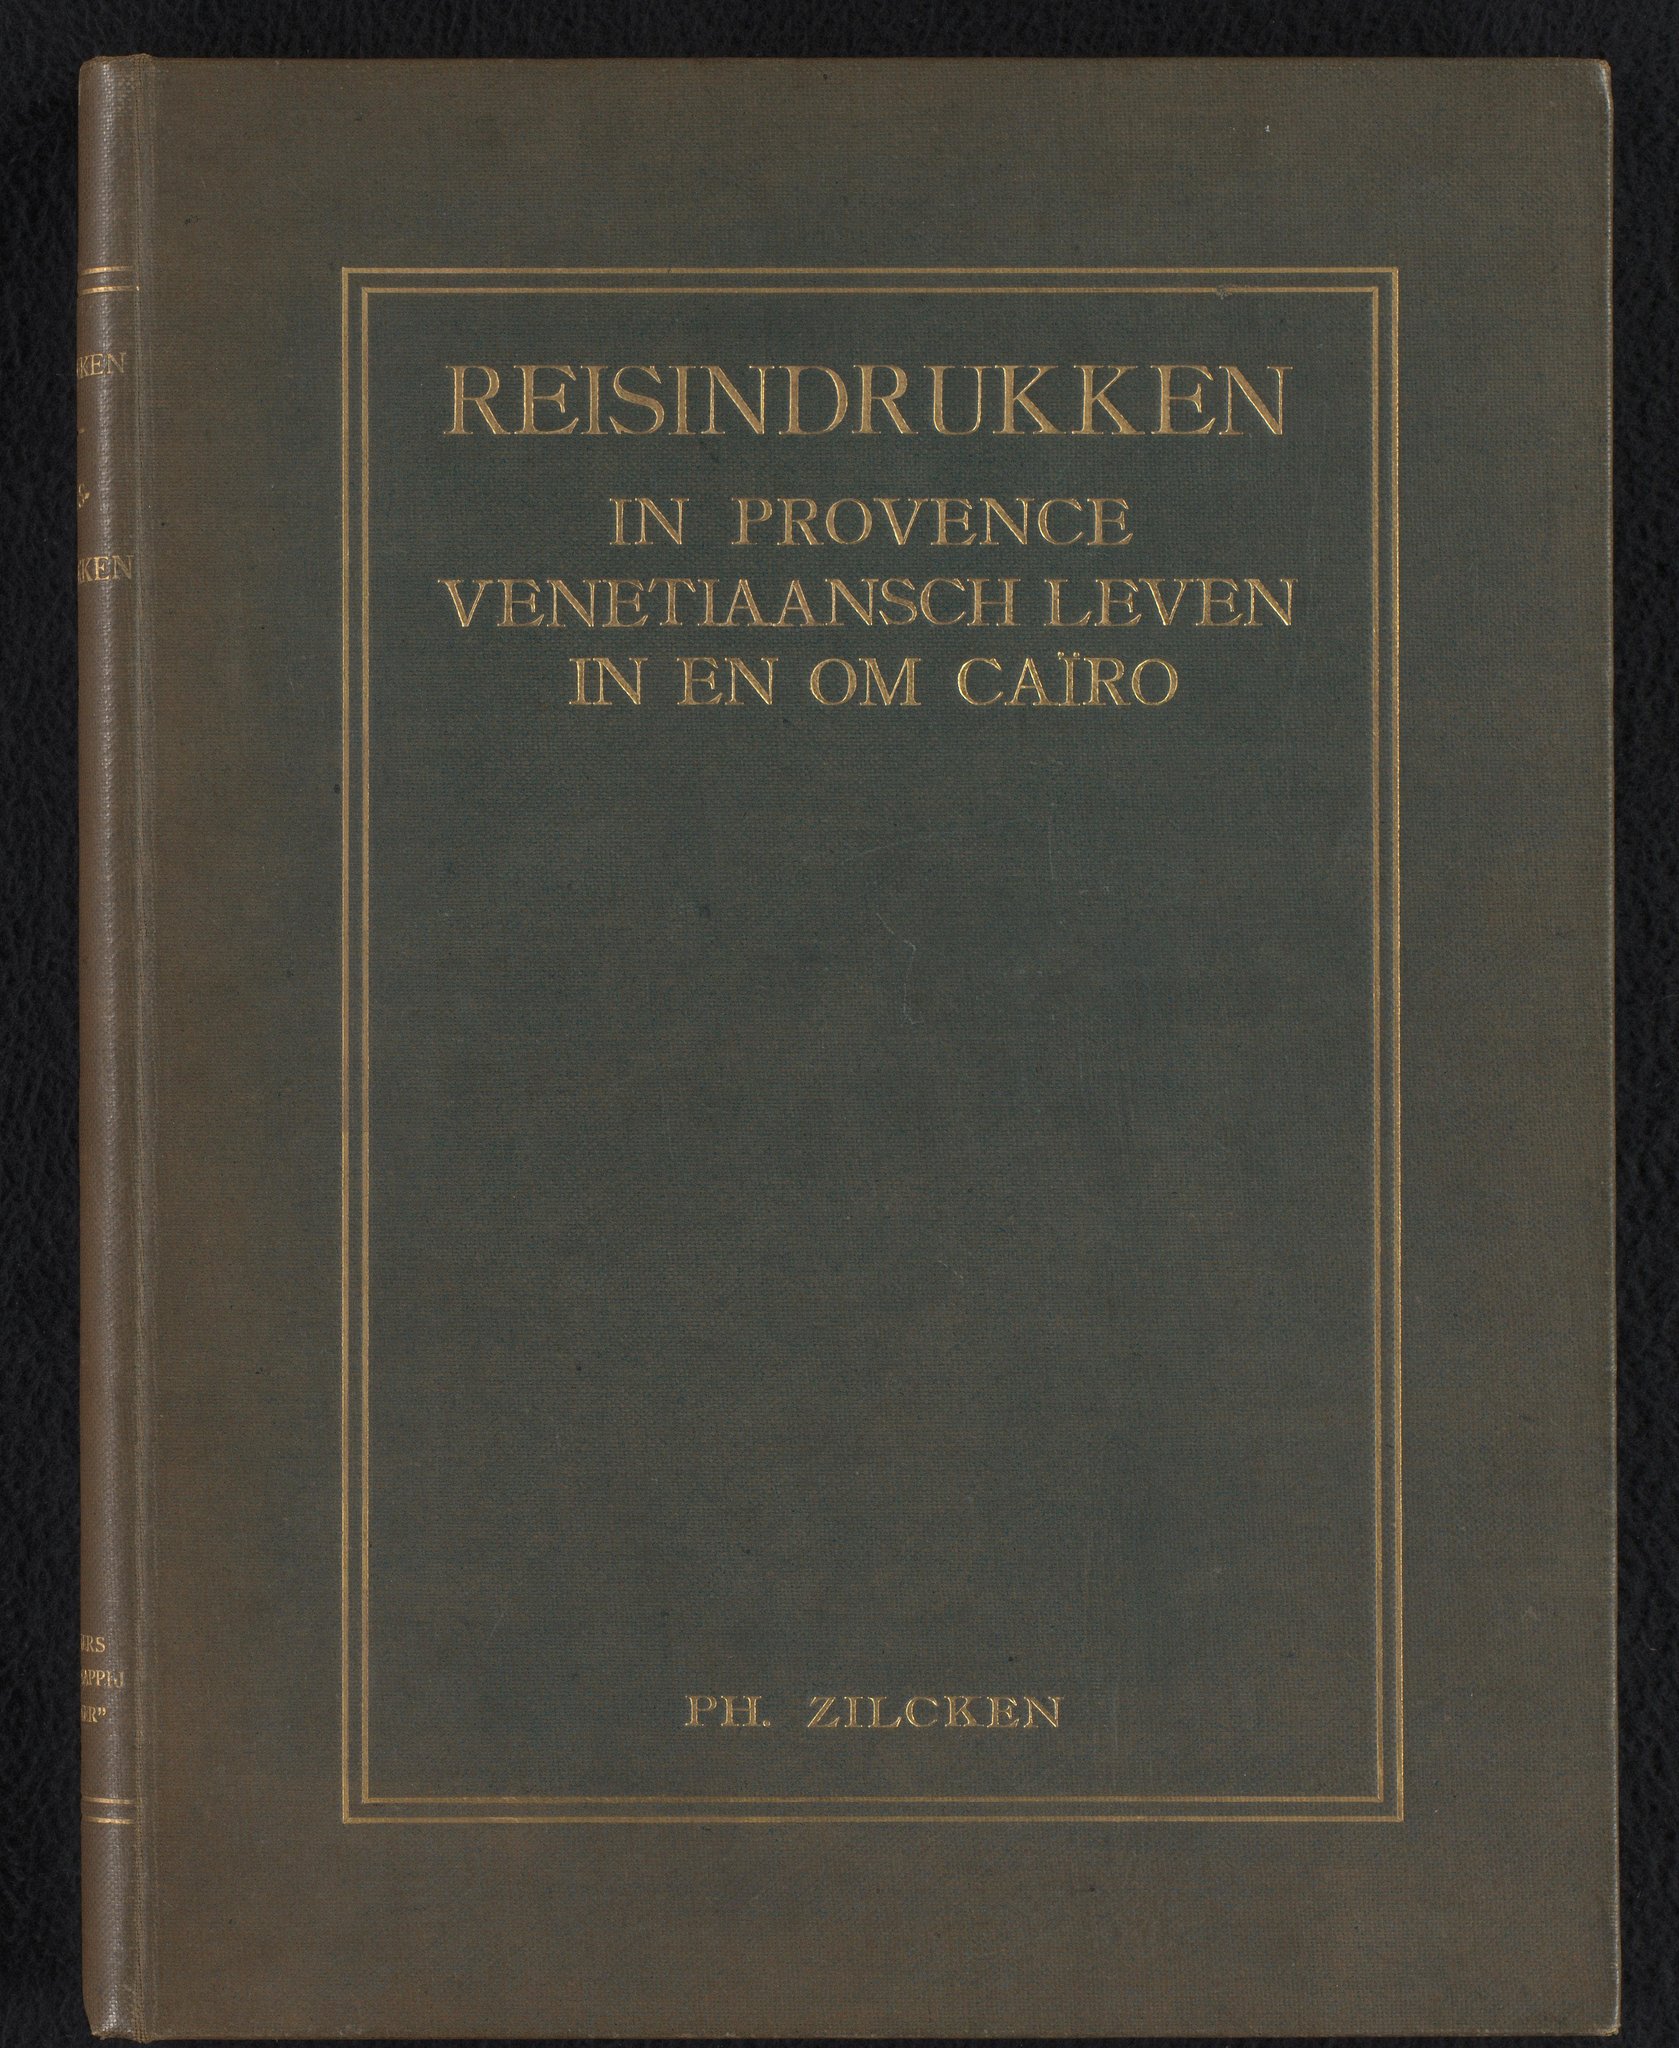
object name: book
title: Reisindrukken in Provence Venetiaansch leven in en om Caïro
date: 1920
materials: cardboard, linen, paper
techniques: bookbinding, printing, etching, letterpress printing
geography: amsterdam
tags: print, e.g.: engraving, etching, lithograph, book, travelling; tourism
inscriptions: collector's mark: Lugt 2760, collector's mark: Lugt 2228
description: Boek met reisverslag (119 pagina's tekst) en twaalf topografische etsen.